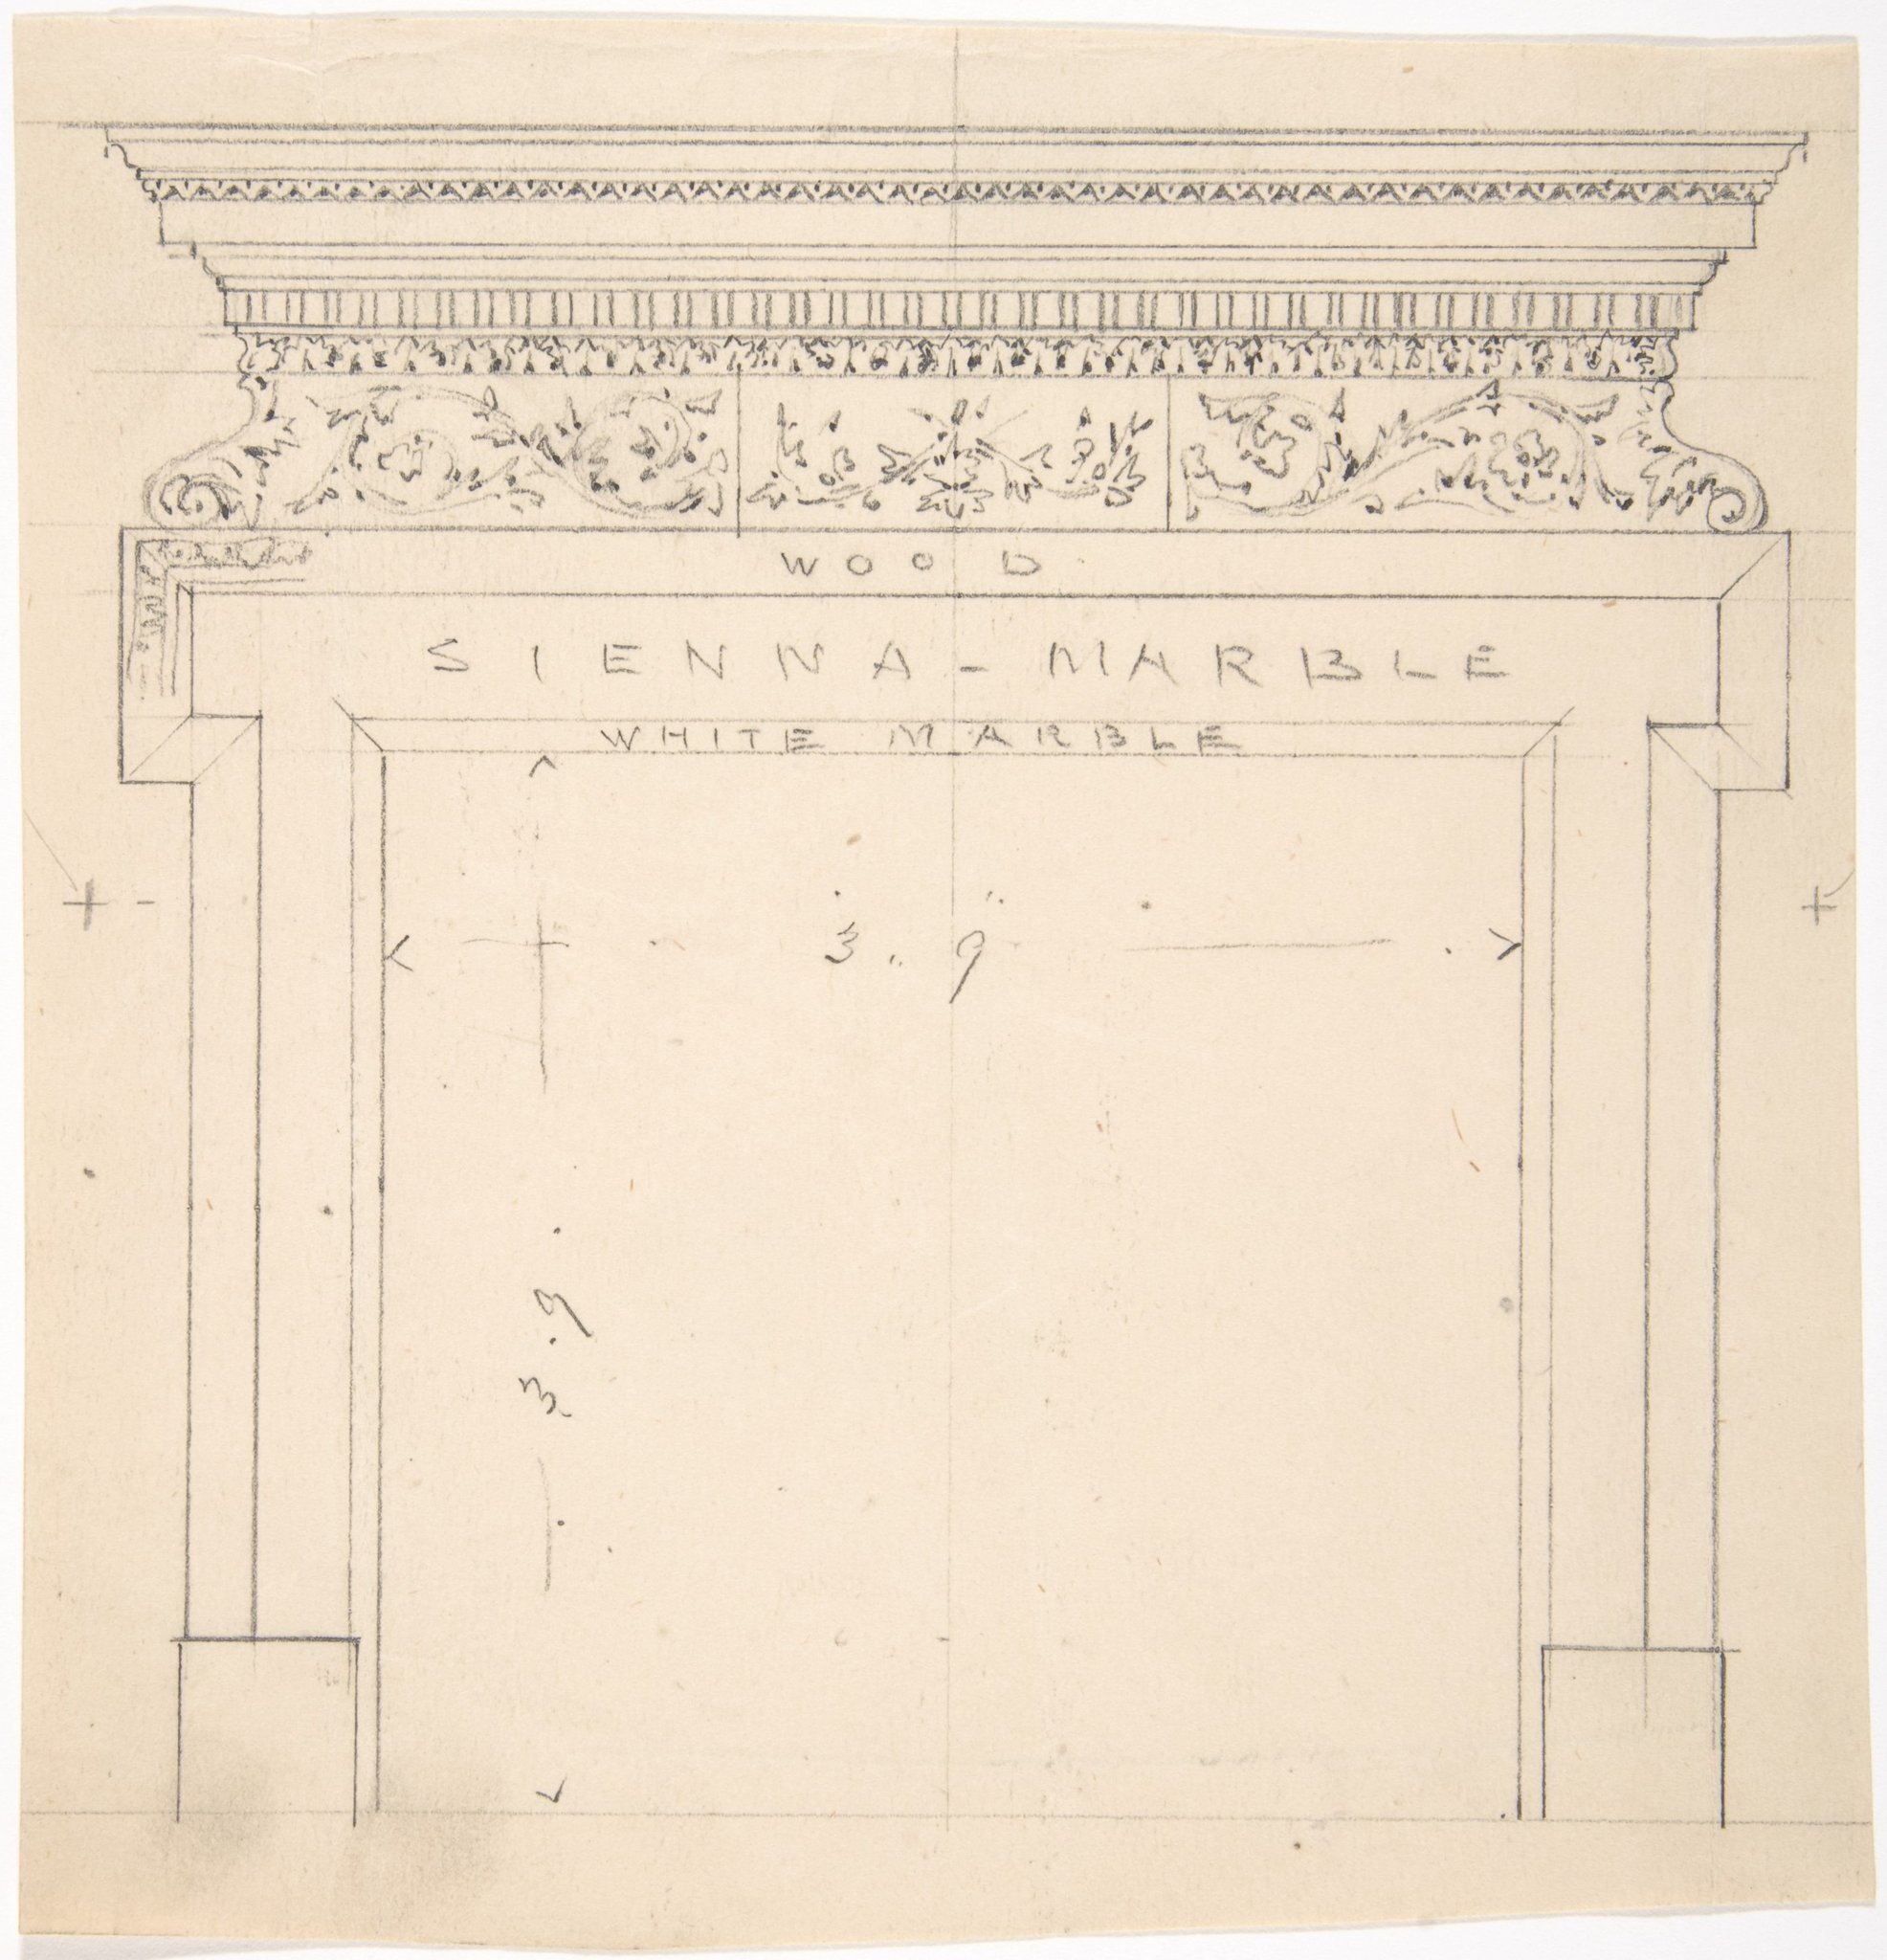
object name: drawing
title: Design for a Marble Fireplace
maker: anonymous, british, 19th century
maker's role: artist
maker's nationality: british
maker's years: 1800-1900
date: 1801-1900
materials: graphite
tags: fireplaces